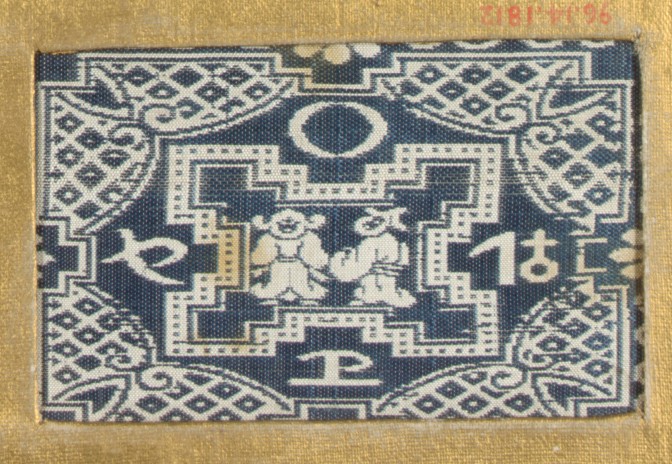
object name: piece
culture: japanese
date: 1701-1900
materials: silk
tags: human figures